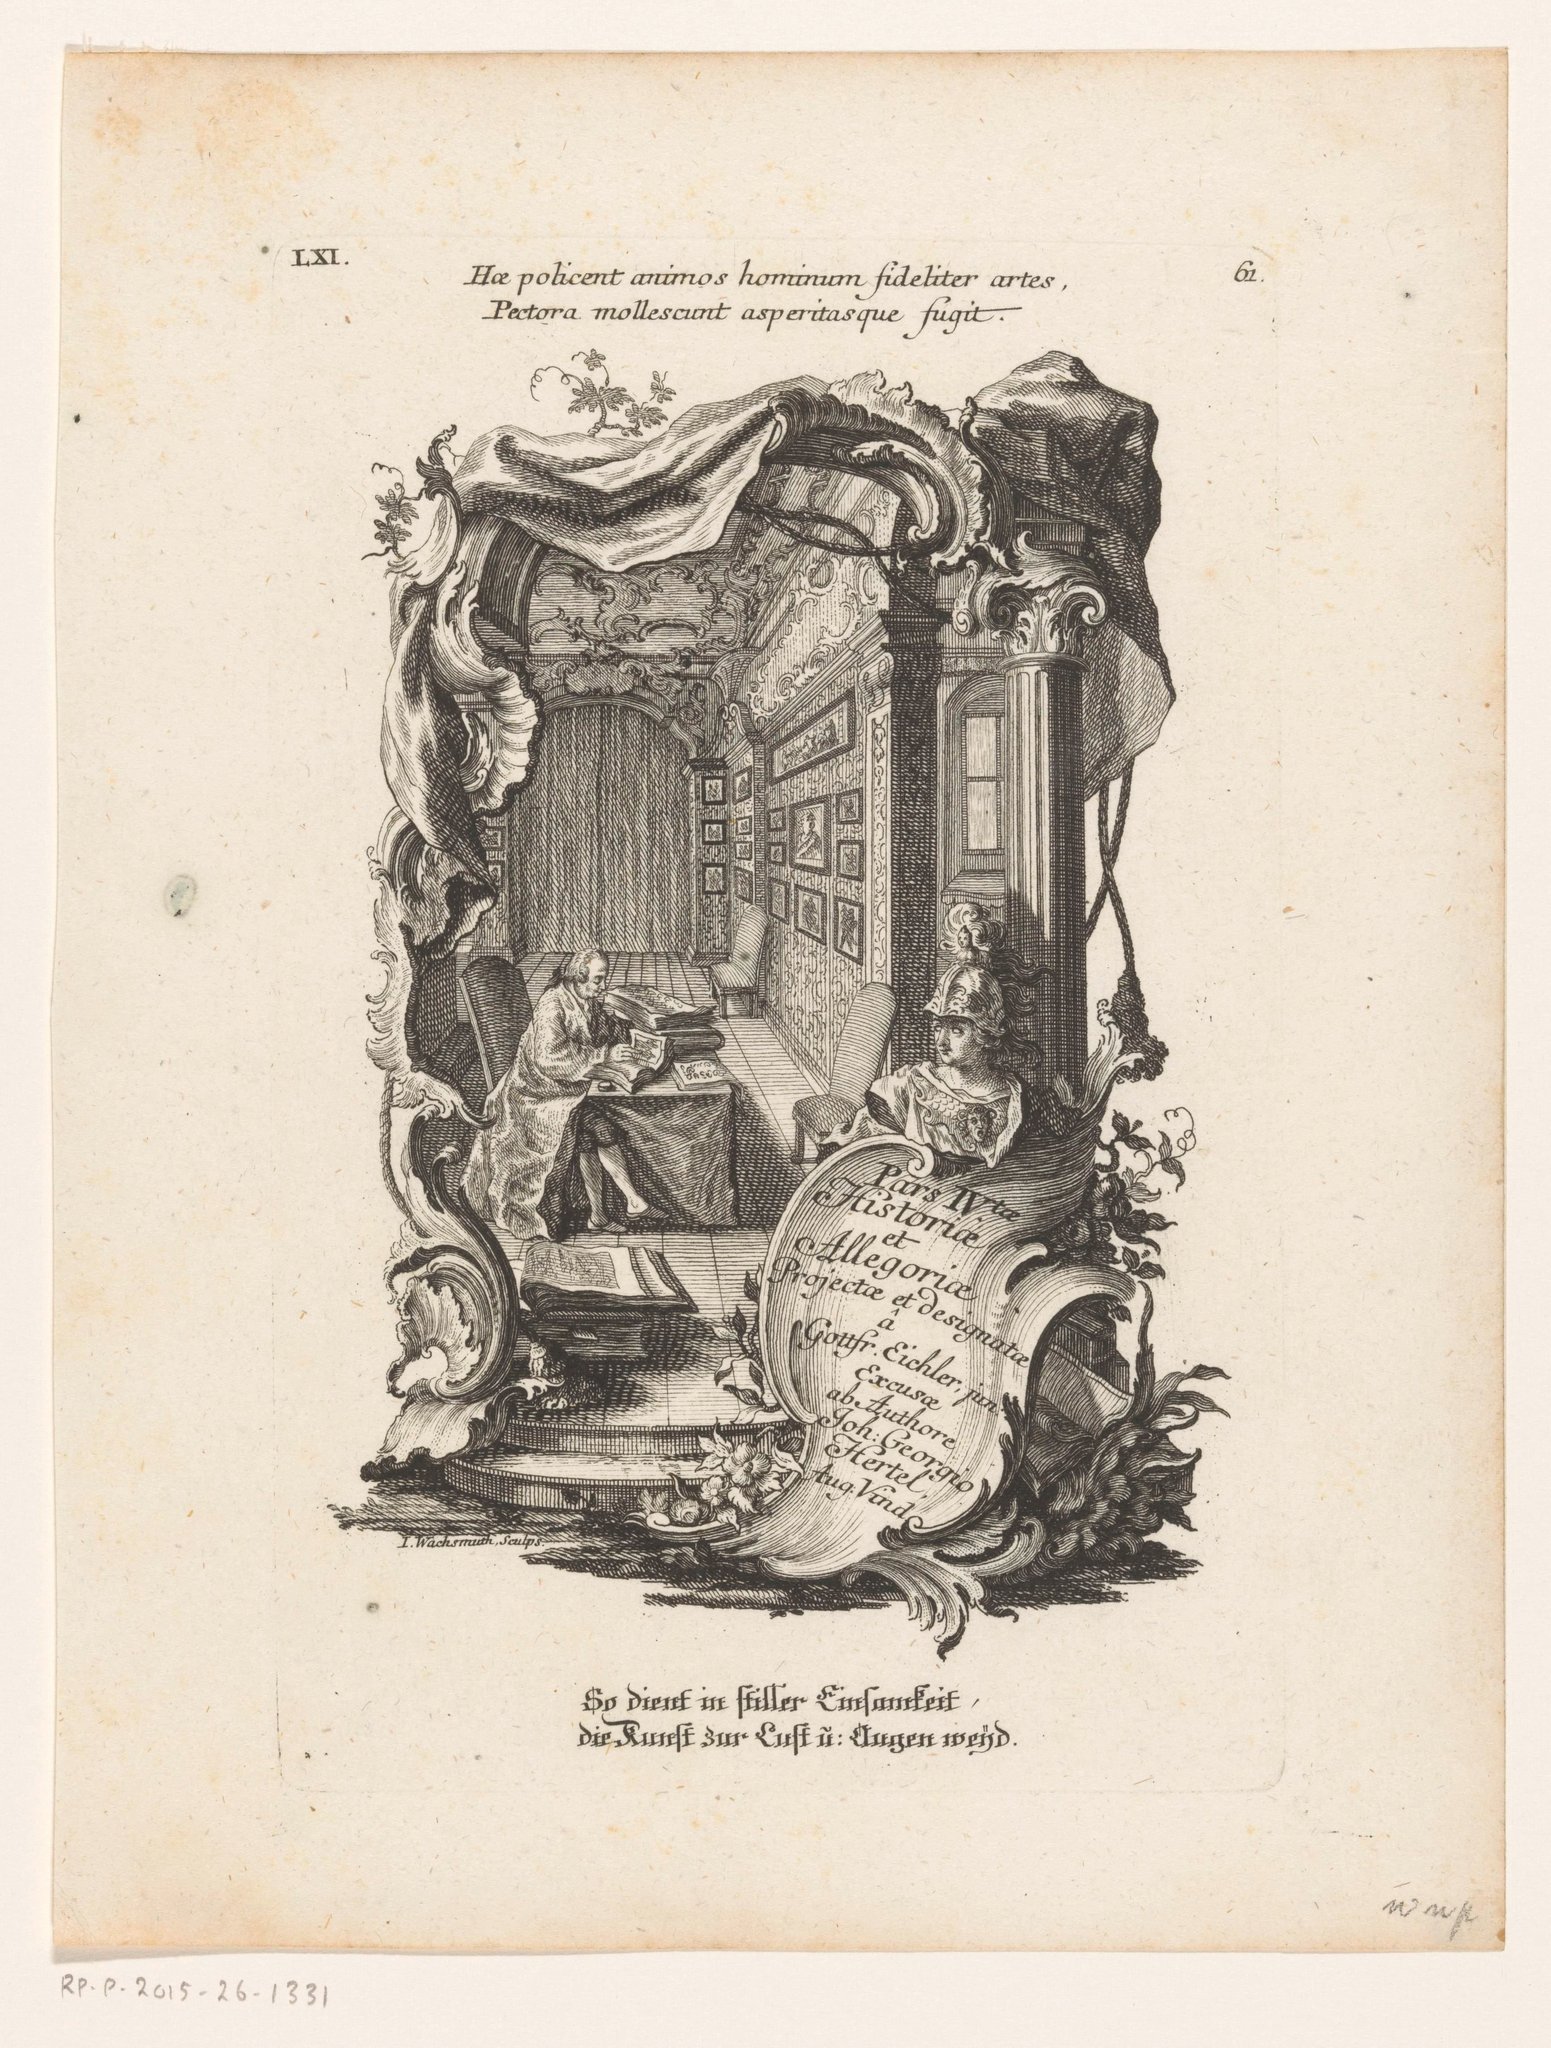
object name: print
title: Geschiedenissen en allegorieën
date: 1758-1760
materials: paper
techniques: etching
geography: augsburg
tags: rocaille ornament, wisdom; 'sapienza', 'sapienza humana', 'sapienza vera' (ripa), newspaper, news-sheet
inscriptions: collector's mark: Lugt 2228, collector's mark: Lugt 4779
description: De lezende man zit achter een leestafel in een kamer met ingelijste werken aan de muur. Op het cartouche op de voorgrond een buste van Minerva. Boven een tweeregelige tekst in het Latijn en onder een tweeregelige tekst in het Duits. Rechtsboven genummerd: 61; rechtsboven: LXI.